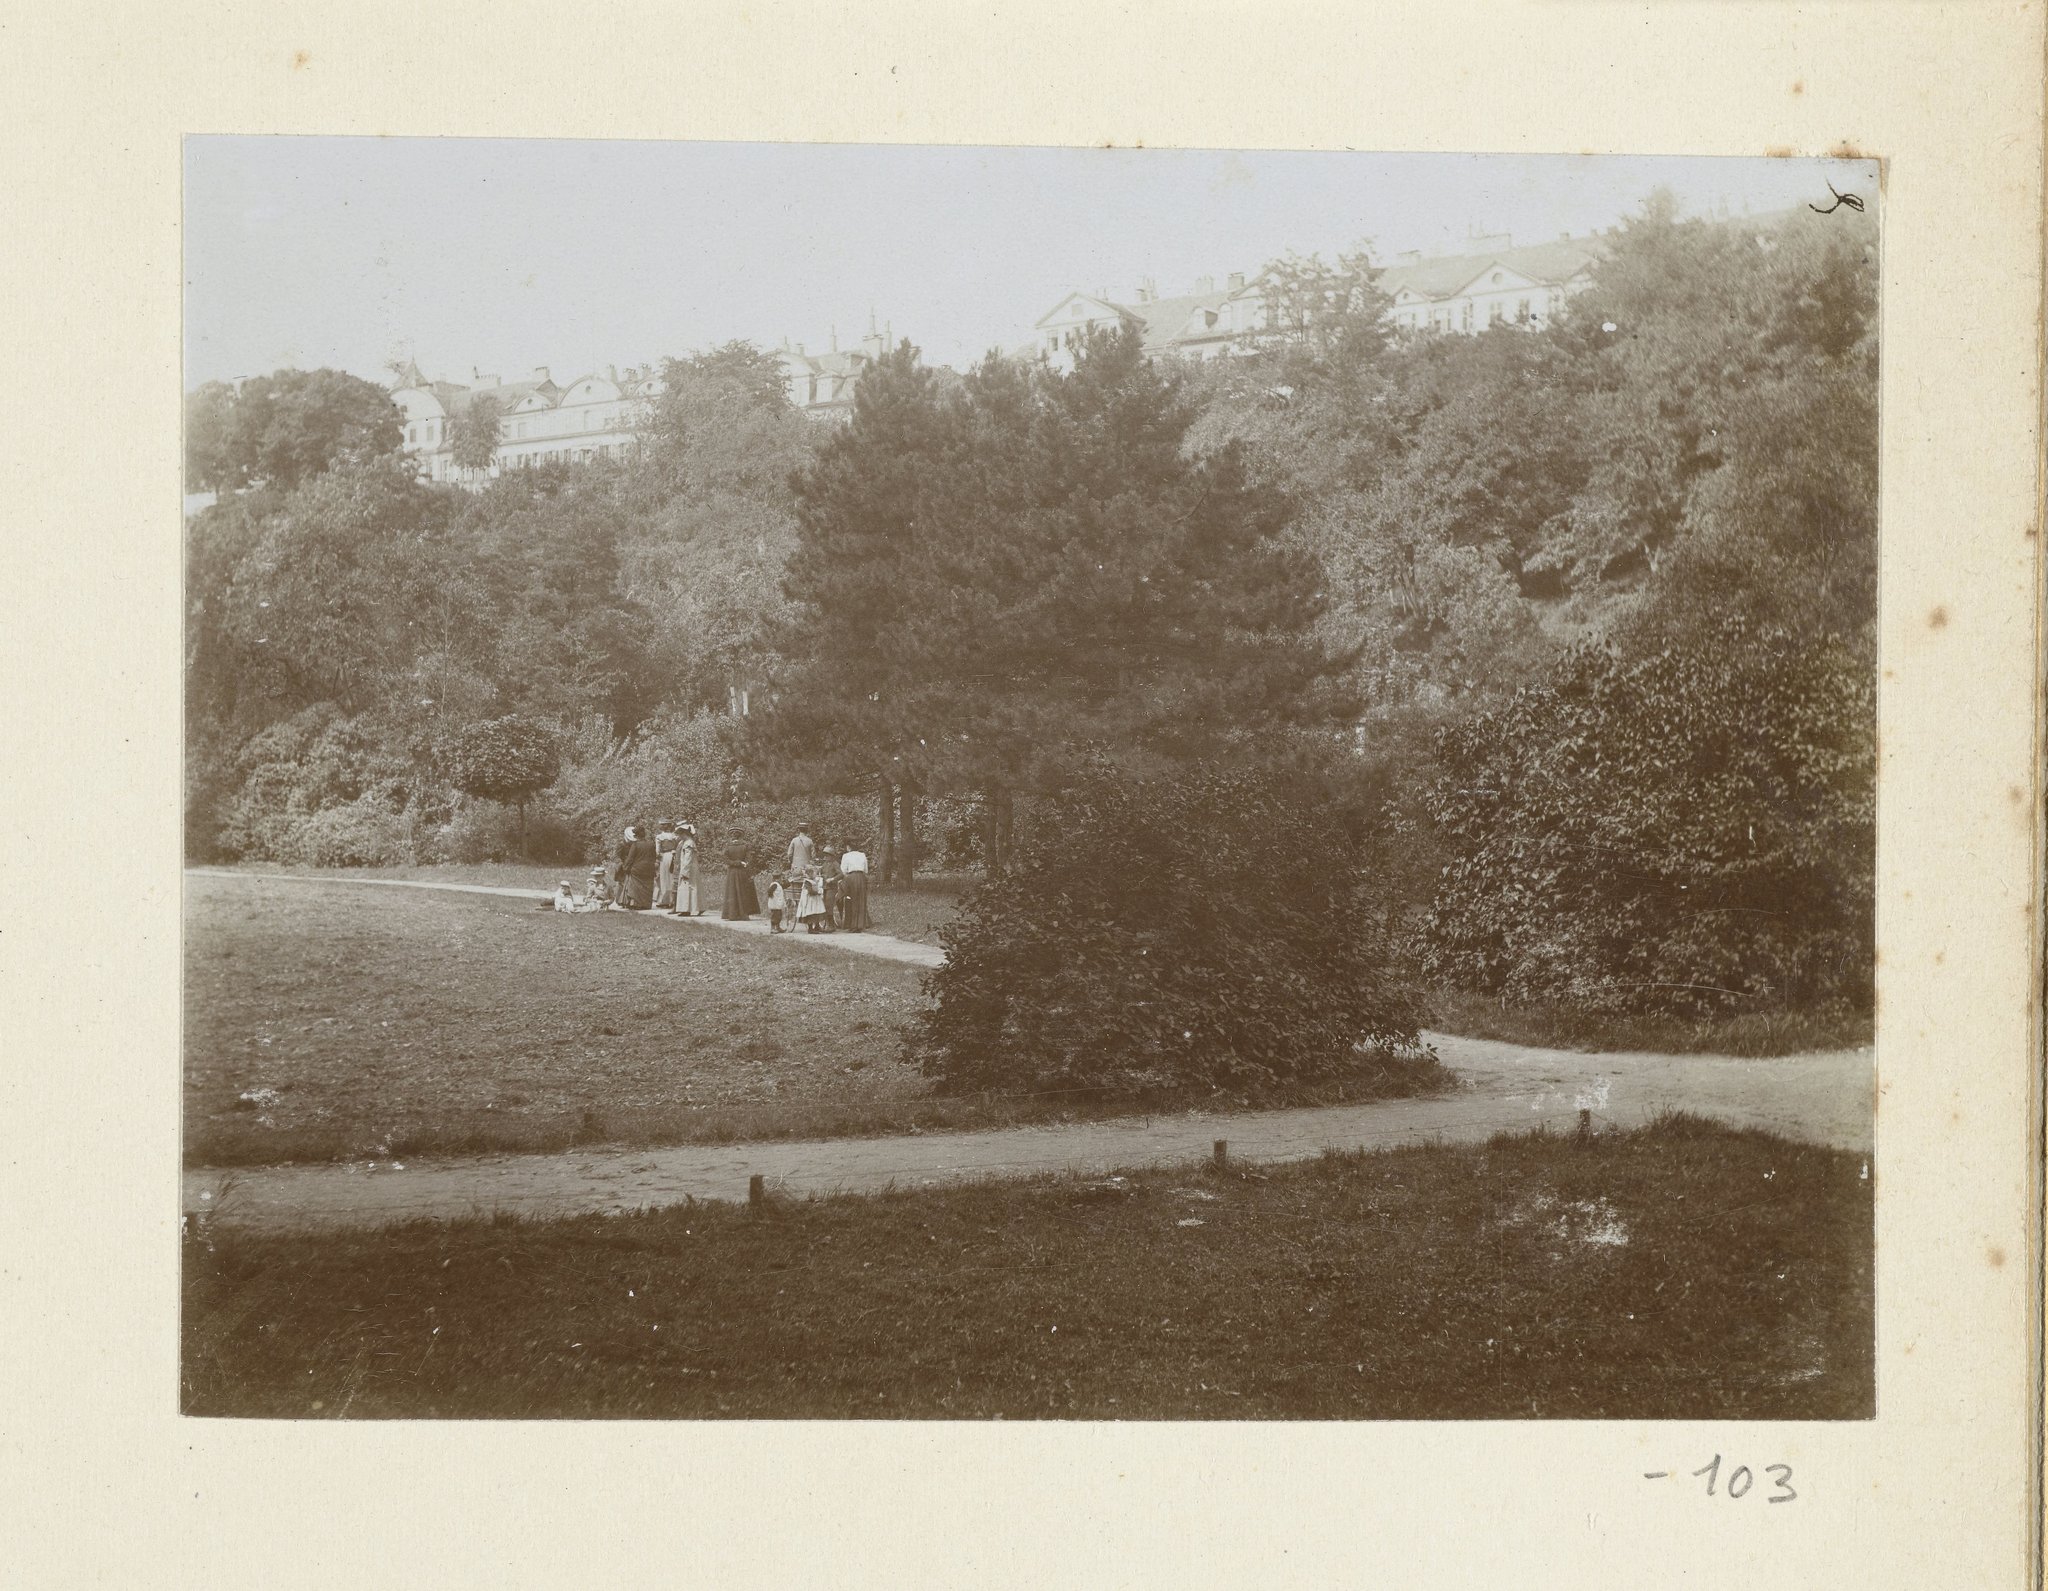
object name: photograph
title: Het gezelschap bij een wandeling in een stadspark in de Harz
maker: geldolph adriaan kessler (dolph)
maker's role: fotograaf, industrieel, voetballer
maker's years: 1884-1945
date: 1903-1908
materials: cardboard, photographic support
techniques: gelatin silver print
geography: harz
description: Het gezelschap bij een wandeling in een stadspark in vermoedelijk de Harz. Onderdeel van het fotoalbum van Dolph Kessler met opnamen die hij maakte tijdens zijn verblijf in Engeland en op een wereldreis die hij als secretaris van Henri Deterding (directeur Koninklijke Olie) ondernam naar Nederlands-Indië, Japan, China en de Verenigde Staten, tussen 1906 en 1908.